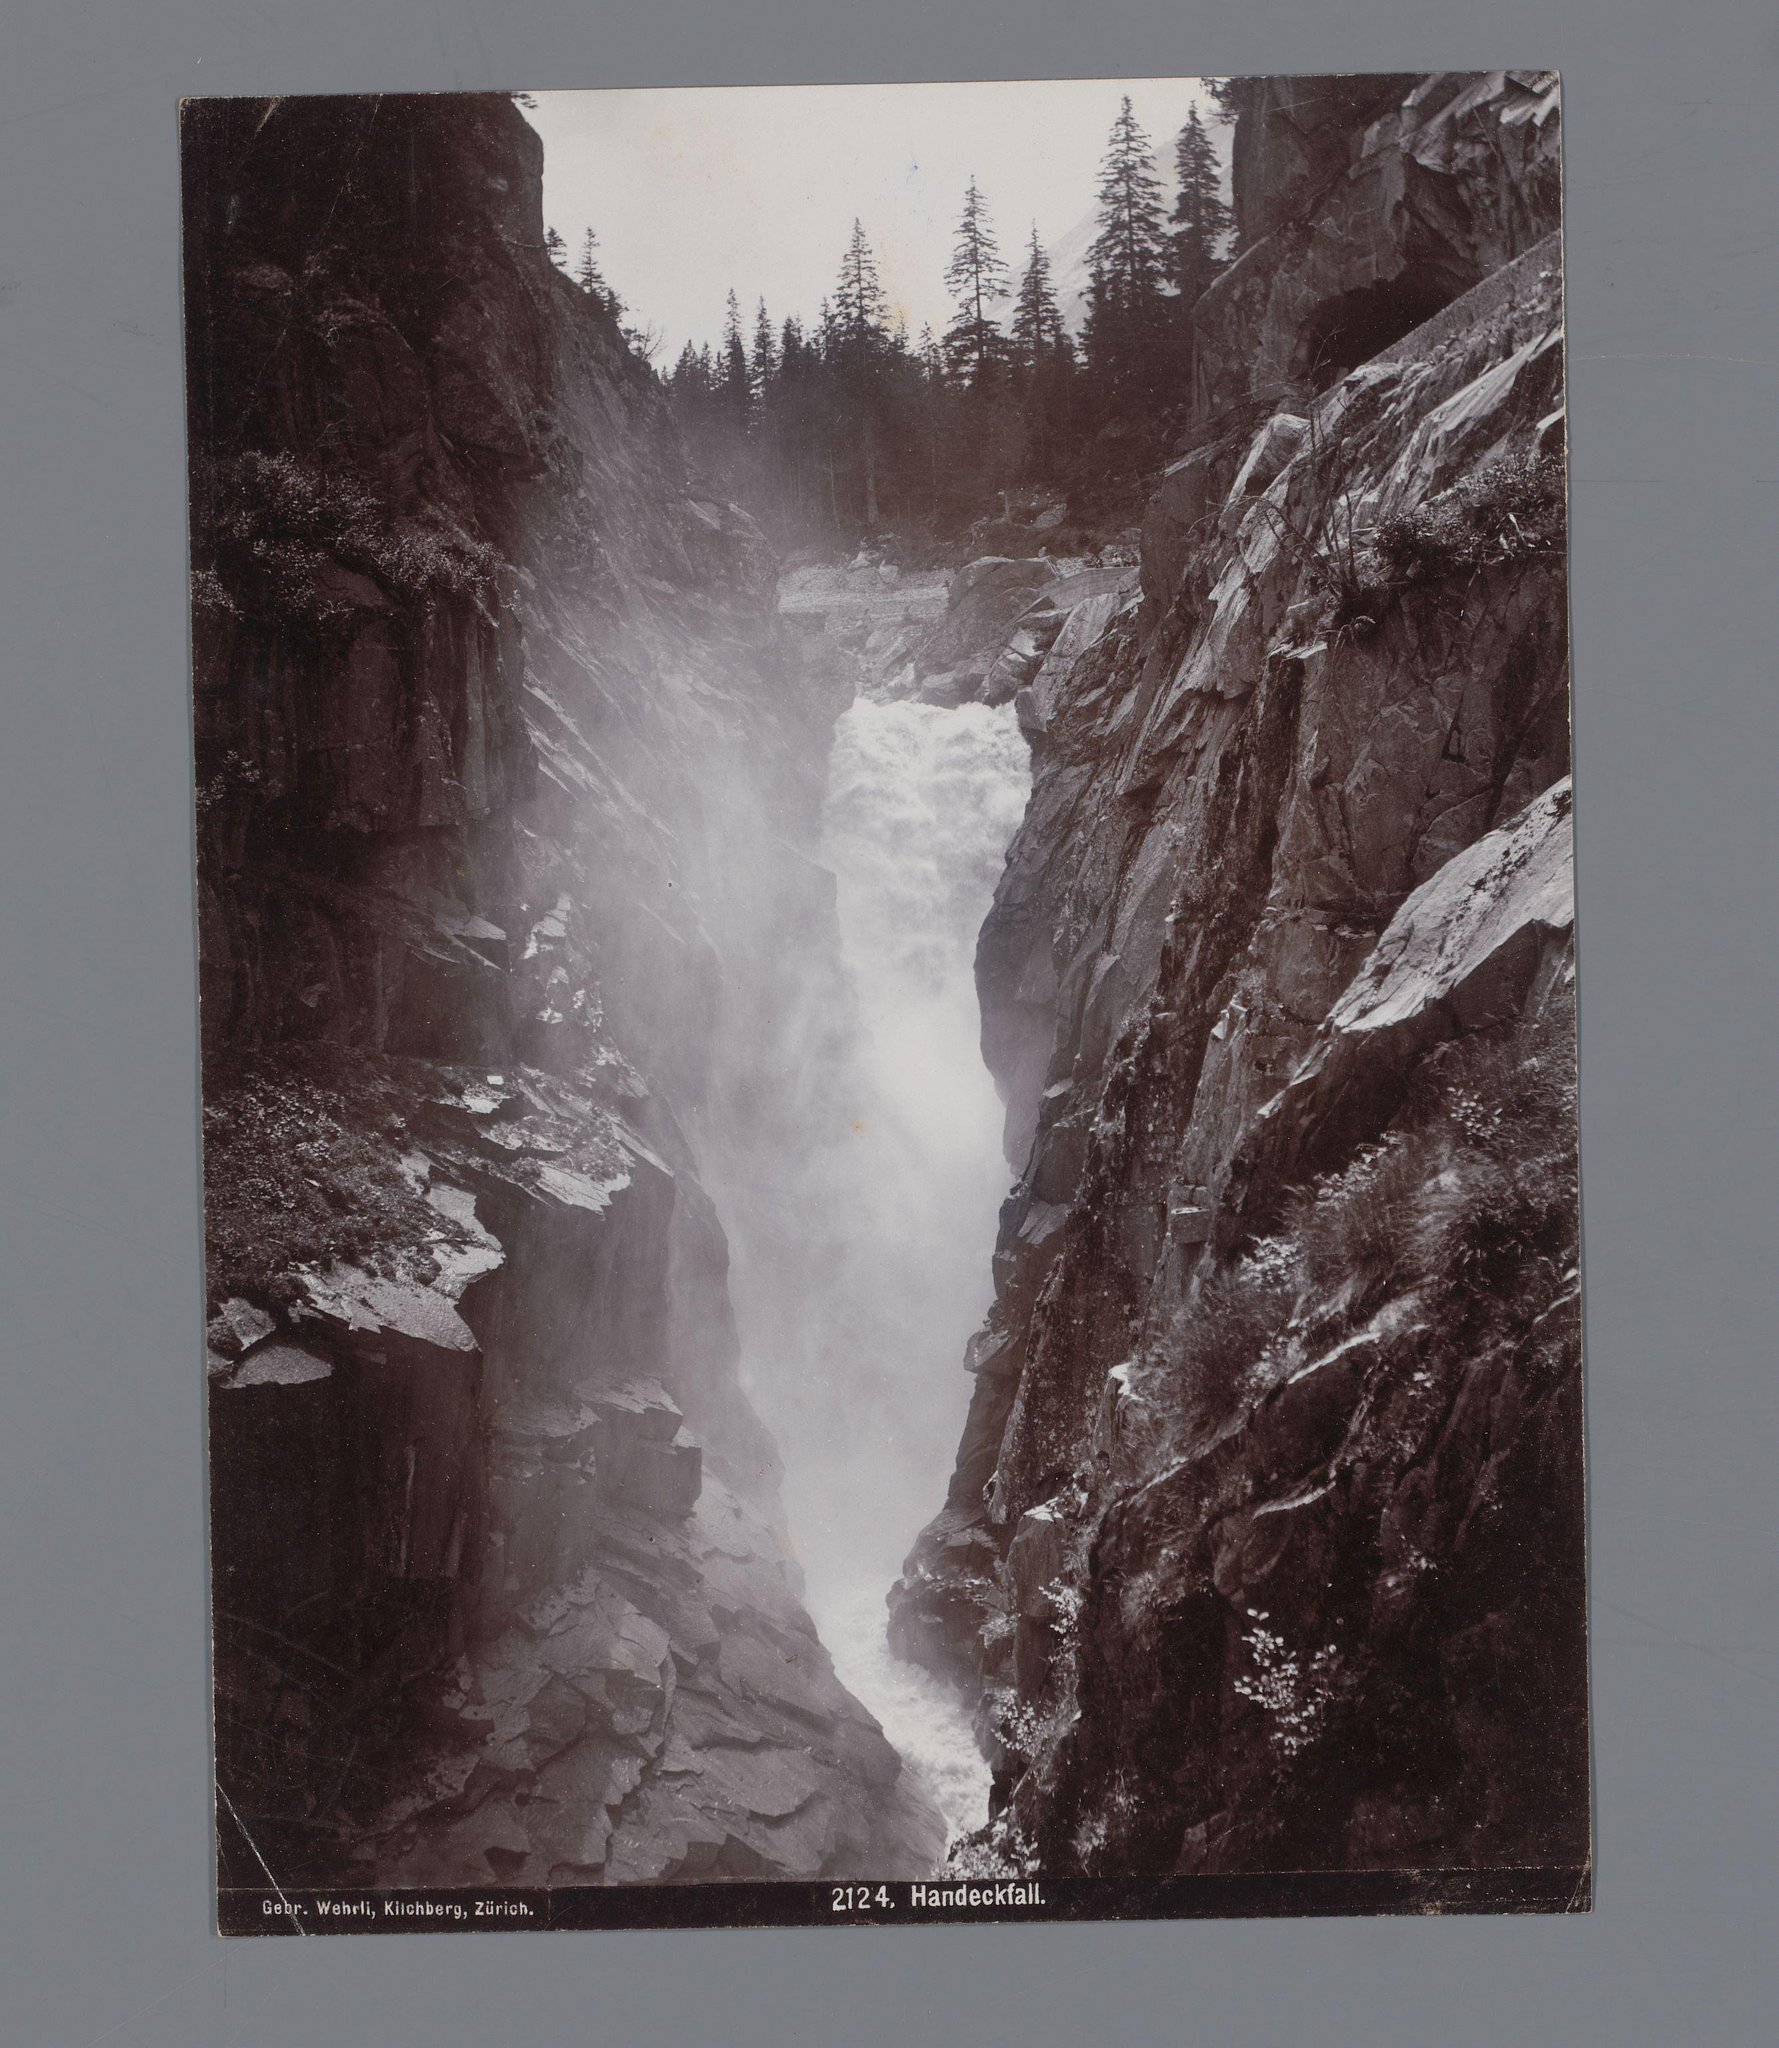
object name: photograph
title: Waterval de "Handeckfall", Berner Oberland, Zwitserland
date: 1890-1920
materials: paper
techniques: gelatin silver print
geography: switzerland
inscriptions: inscription: ‘2124. Handeckfall’, inscription: ‘Gebr. Wehrli, Kilchberg, Zürich.’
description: Door een waterval doorkliefd berglandschap, rechts en links steile rotswanden en dennebomen op de achtergrond.